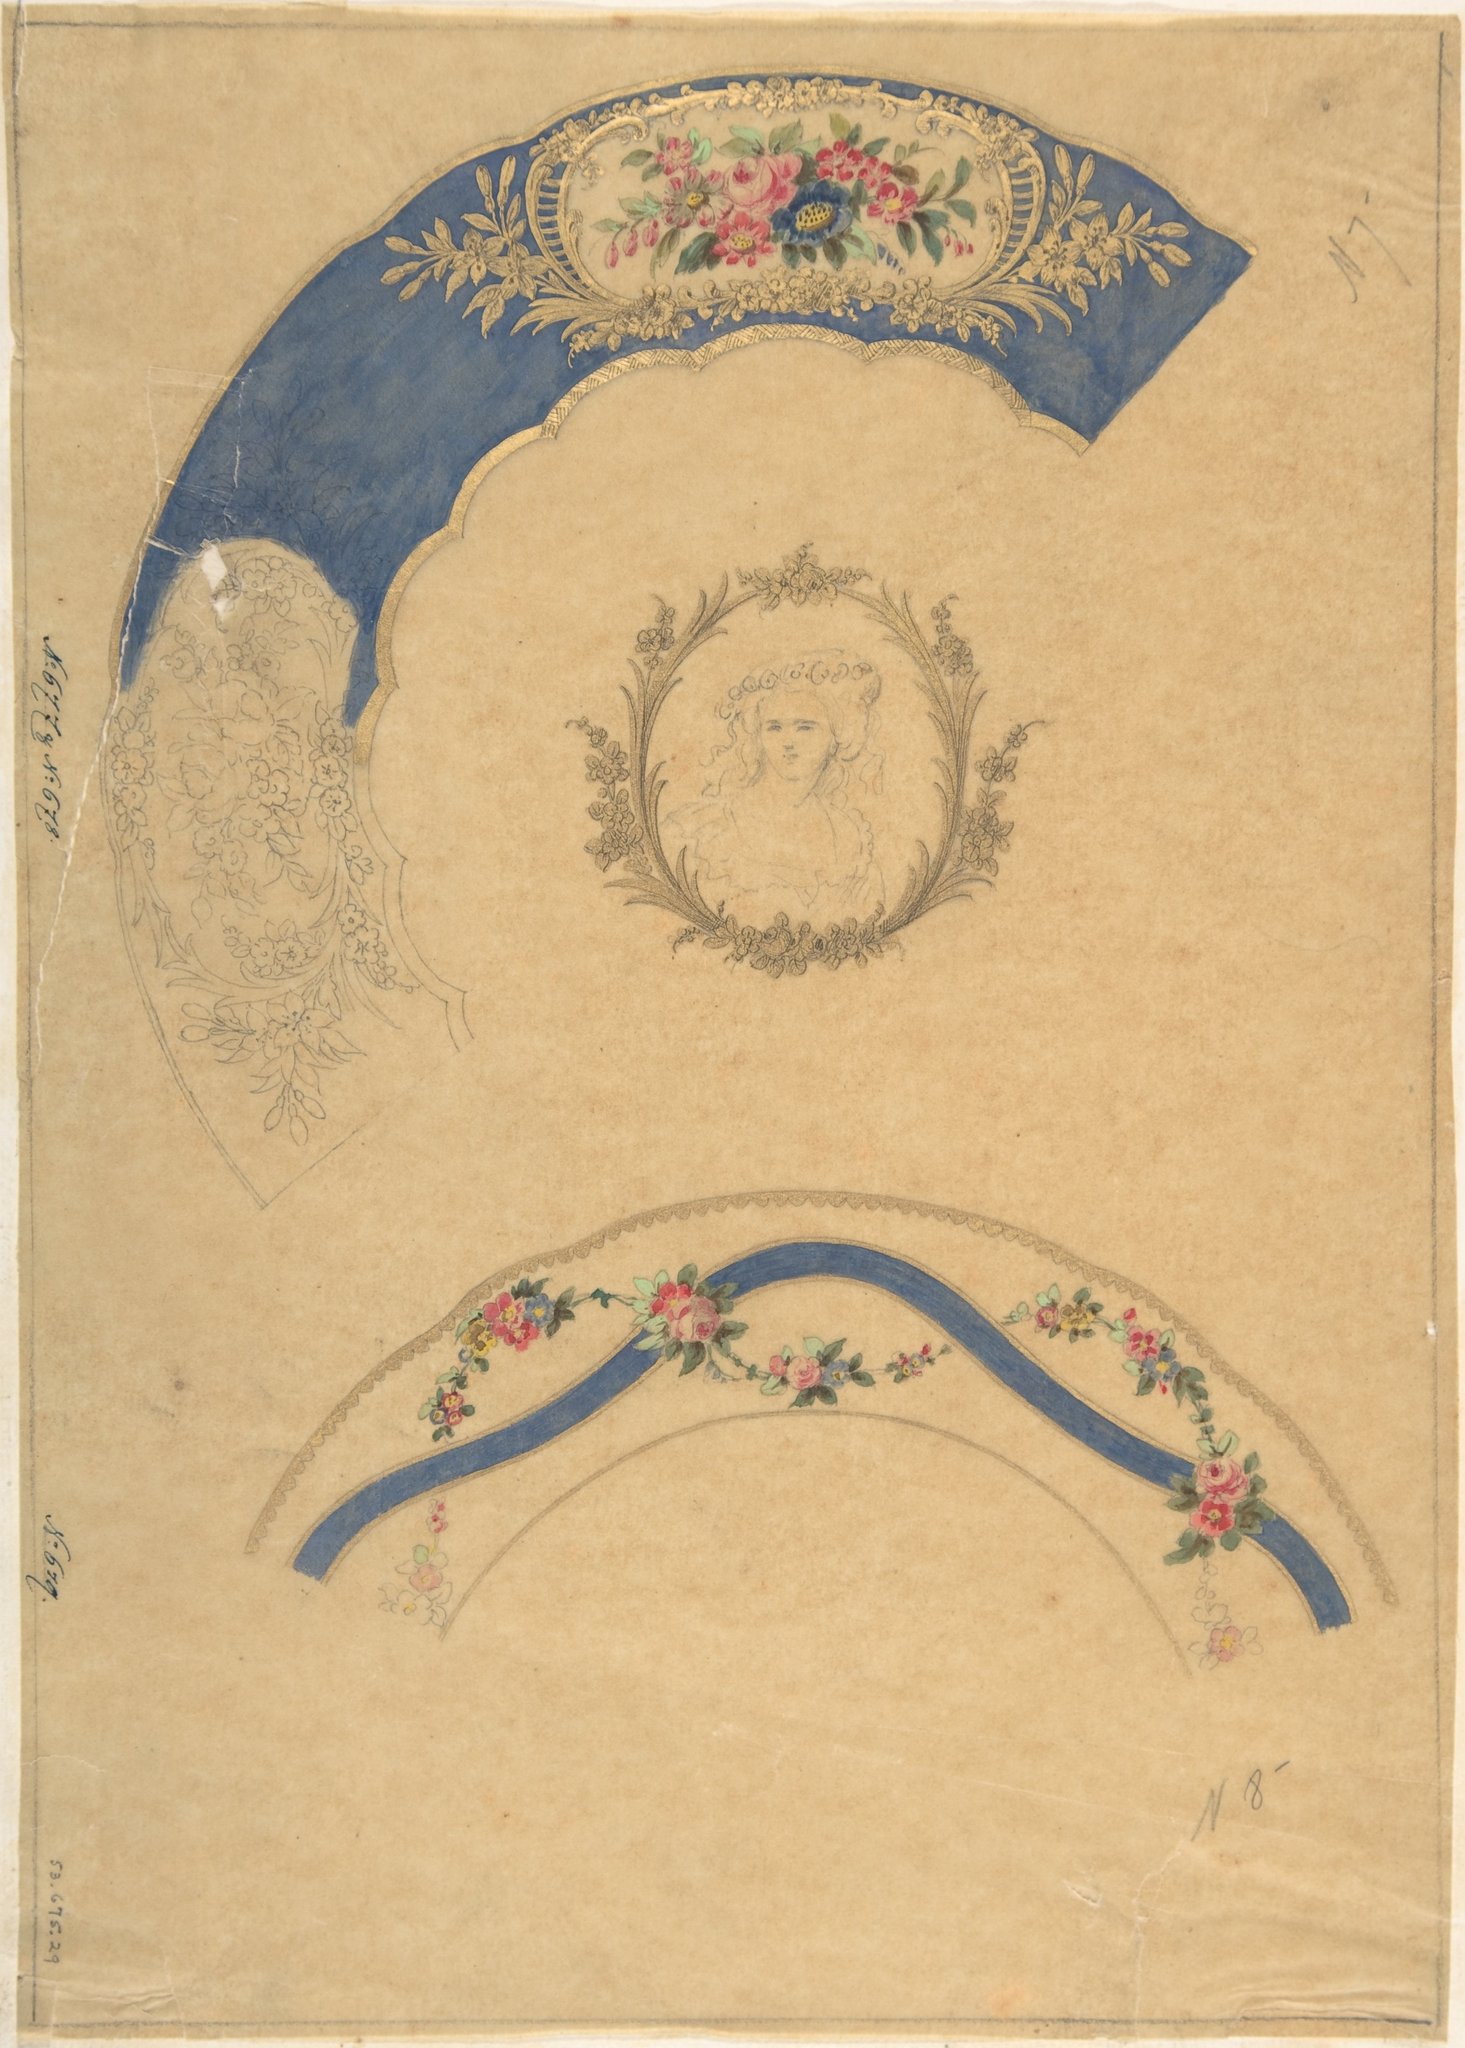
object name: drawing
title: Two Designs for Plate Borders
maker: anonymous, french, 19th century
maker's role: artist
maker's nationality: french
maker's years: 1800-1900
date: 1801-1900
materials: gilt, gold, gouache, graphite, watercolor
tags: portraits,women,flowers